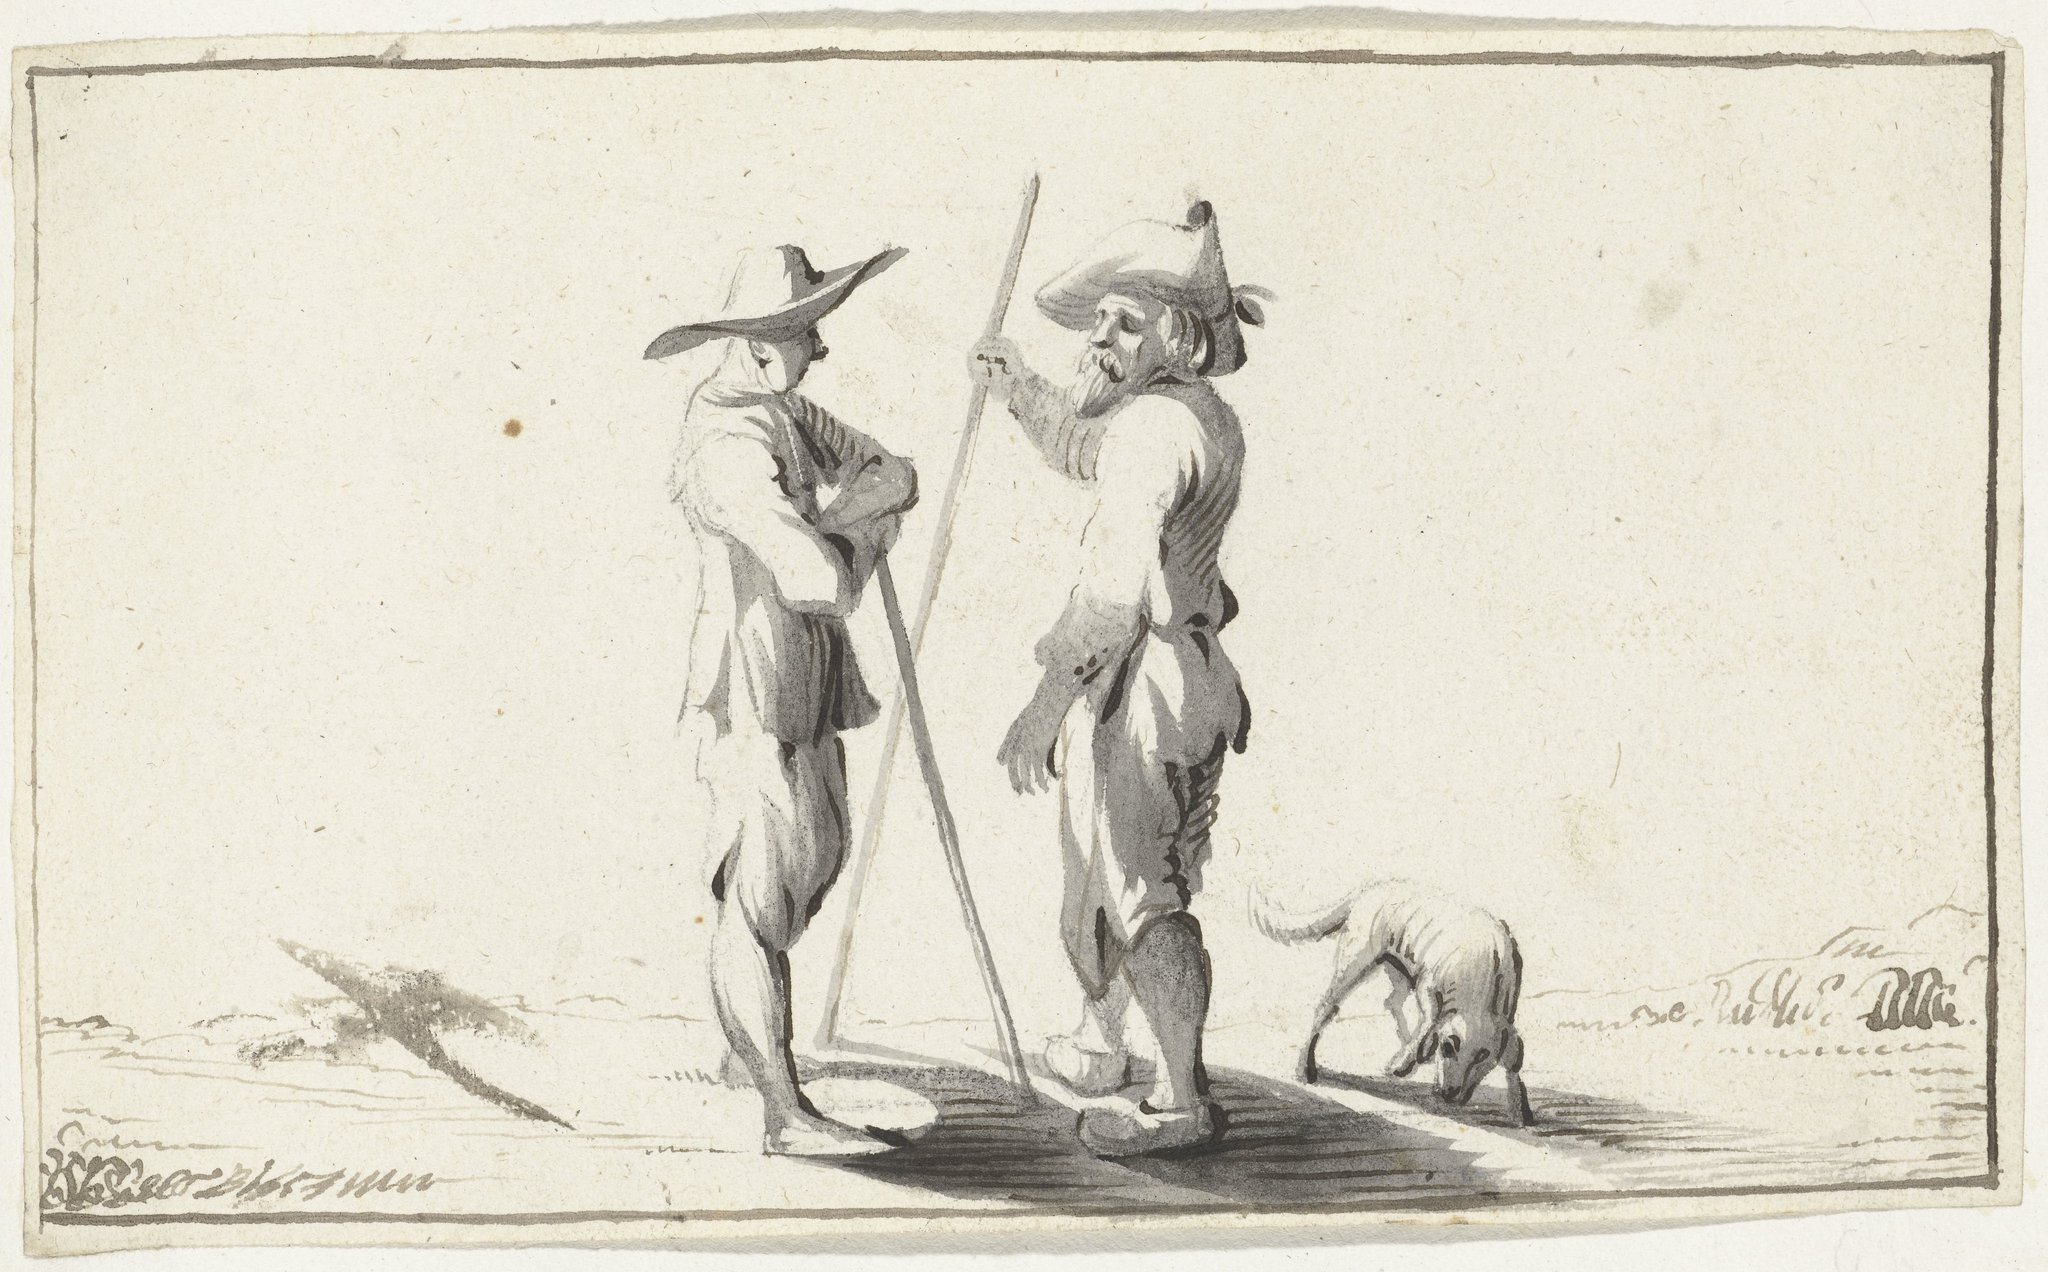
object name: drawing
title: Twee staande mannen in gesprek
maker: harmen ter borch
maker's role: draughtsman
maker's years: 1638-1677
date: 1650-1655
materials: ink, paper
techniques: brush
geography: zwolle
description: Tekening naast een andere tekening geplakt in het Familie-plakboek.